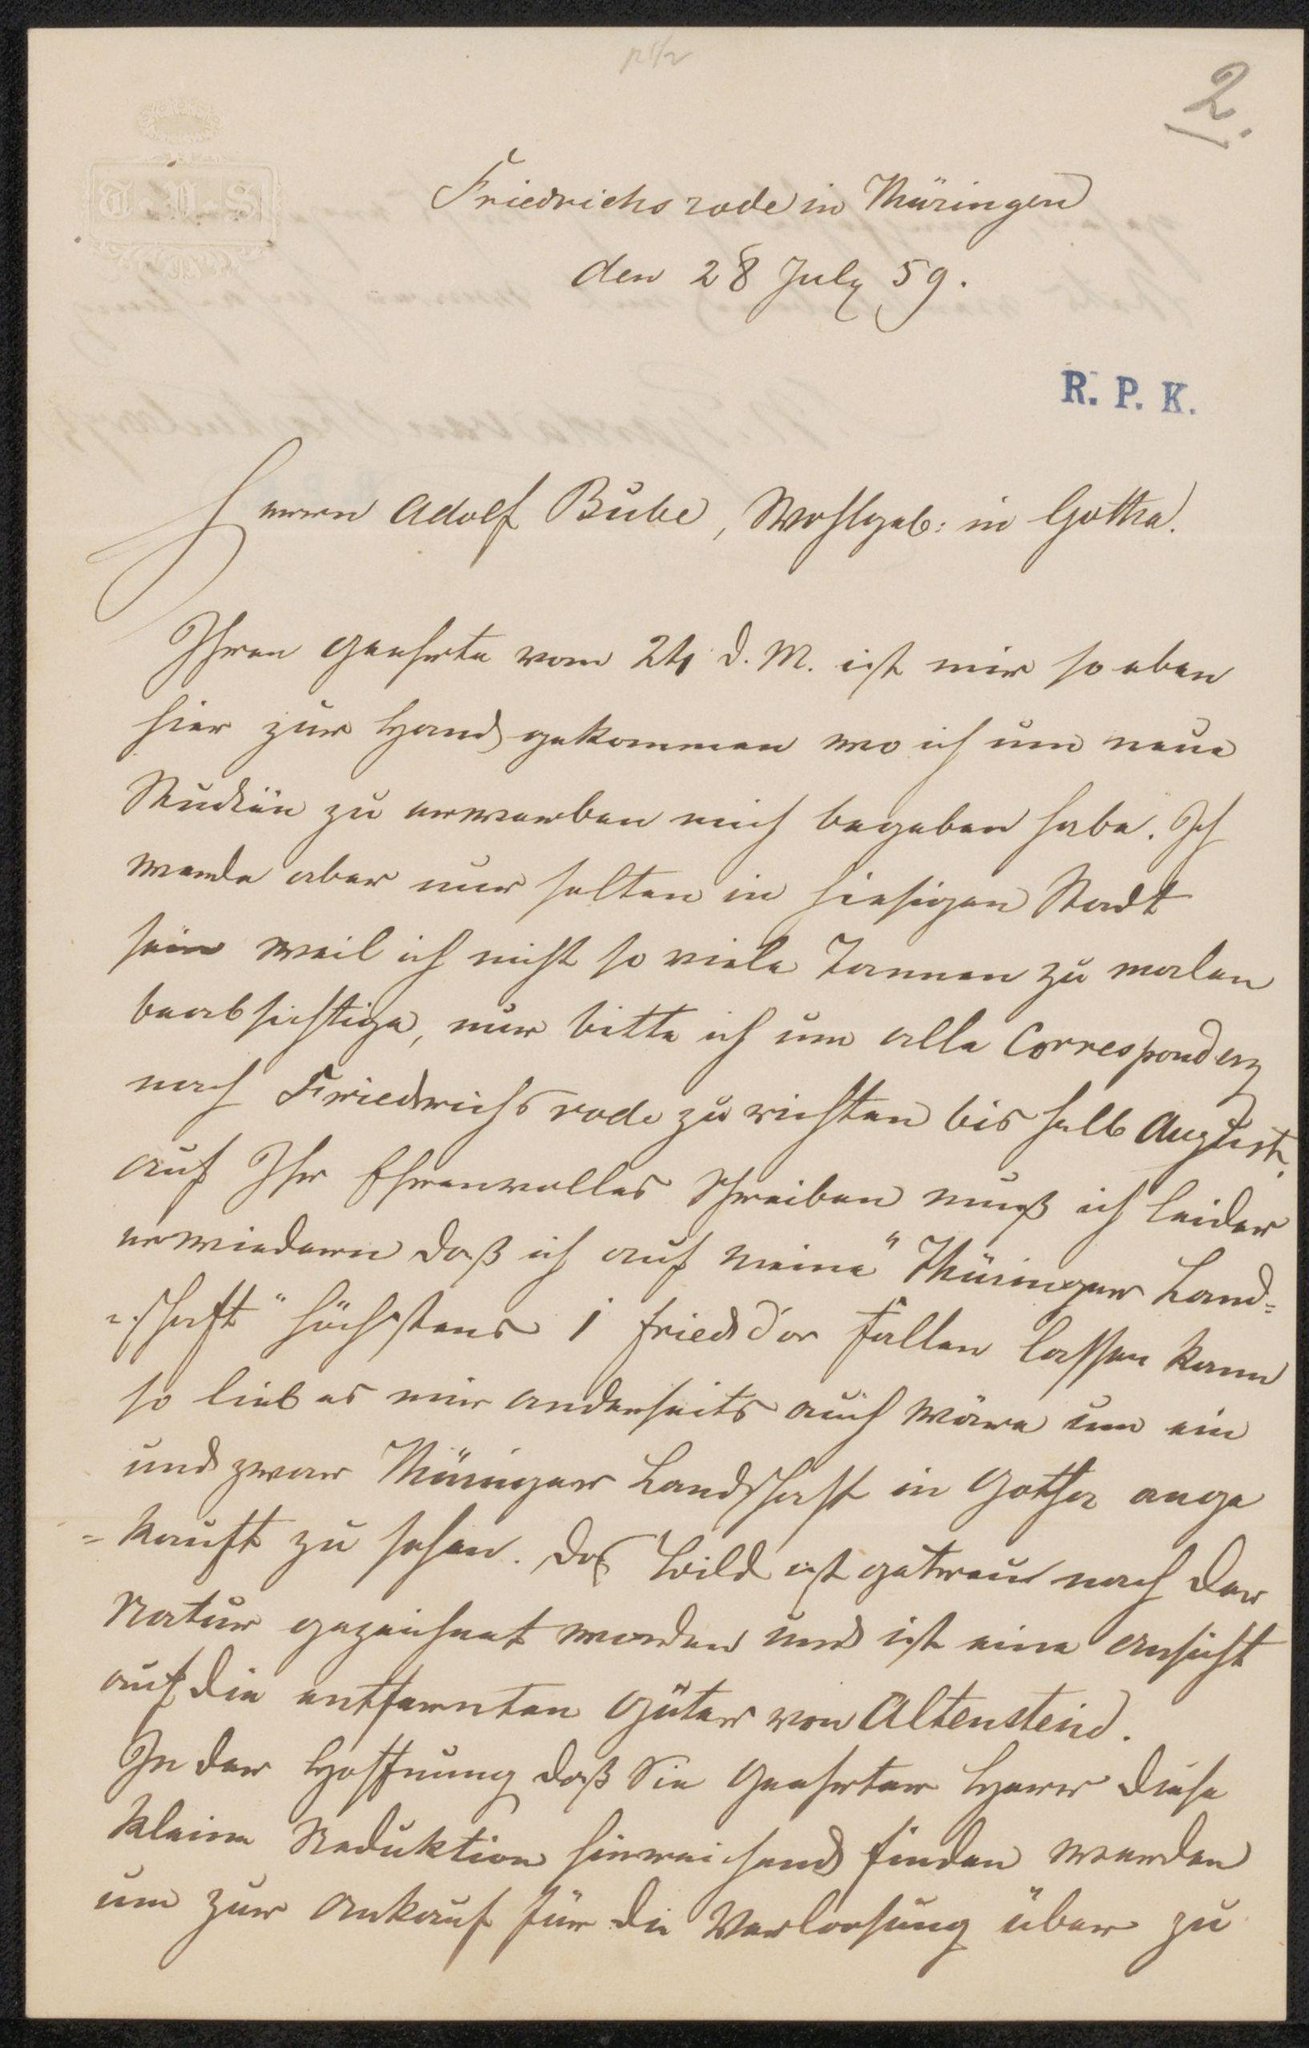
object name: letter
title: Brief aan Adolf Bude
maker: jacobus nicolaas tjarda van starckenborgh stachouwer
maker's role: draughtsman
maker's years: 1822-1895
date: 1859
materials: ink, paper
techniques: pen, writing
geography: friedrichroda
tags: painting (including book-illumination, miniature-painting), money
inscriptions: monogram, collector's mark: Lugt 2233